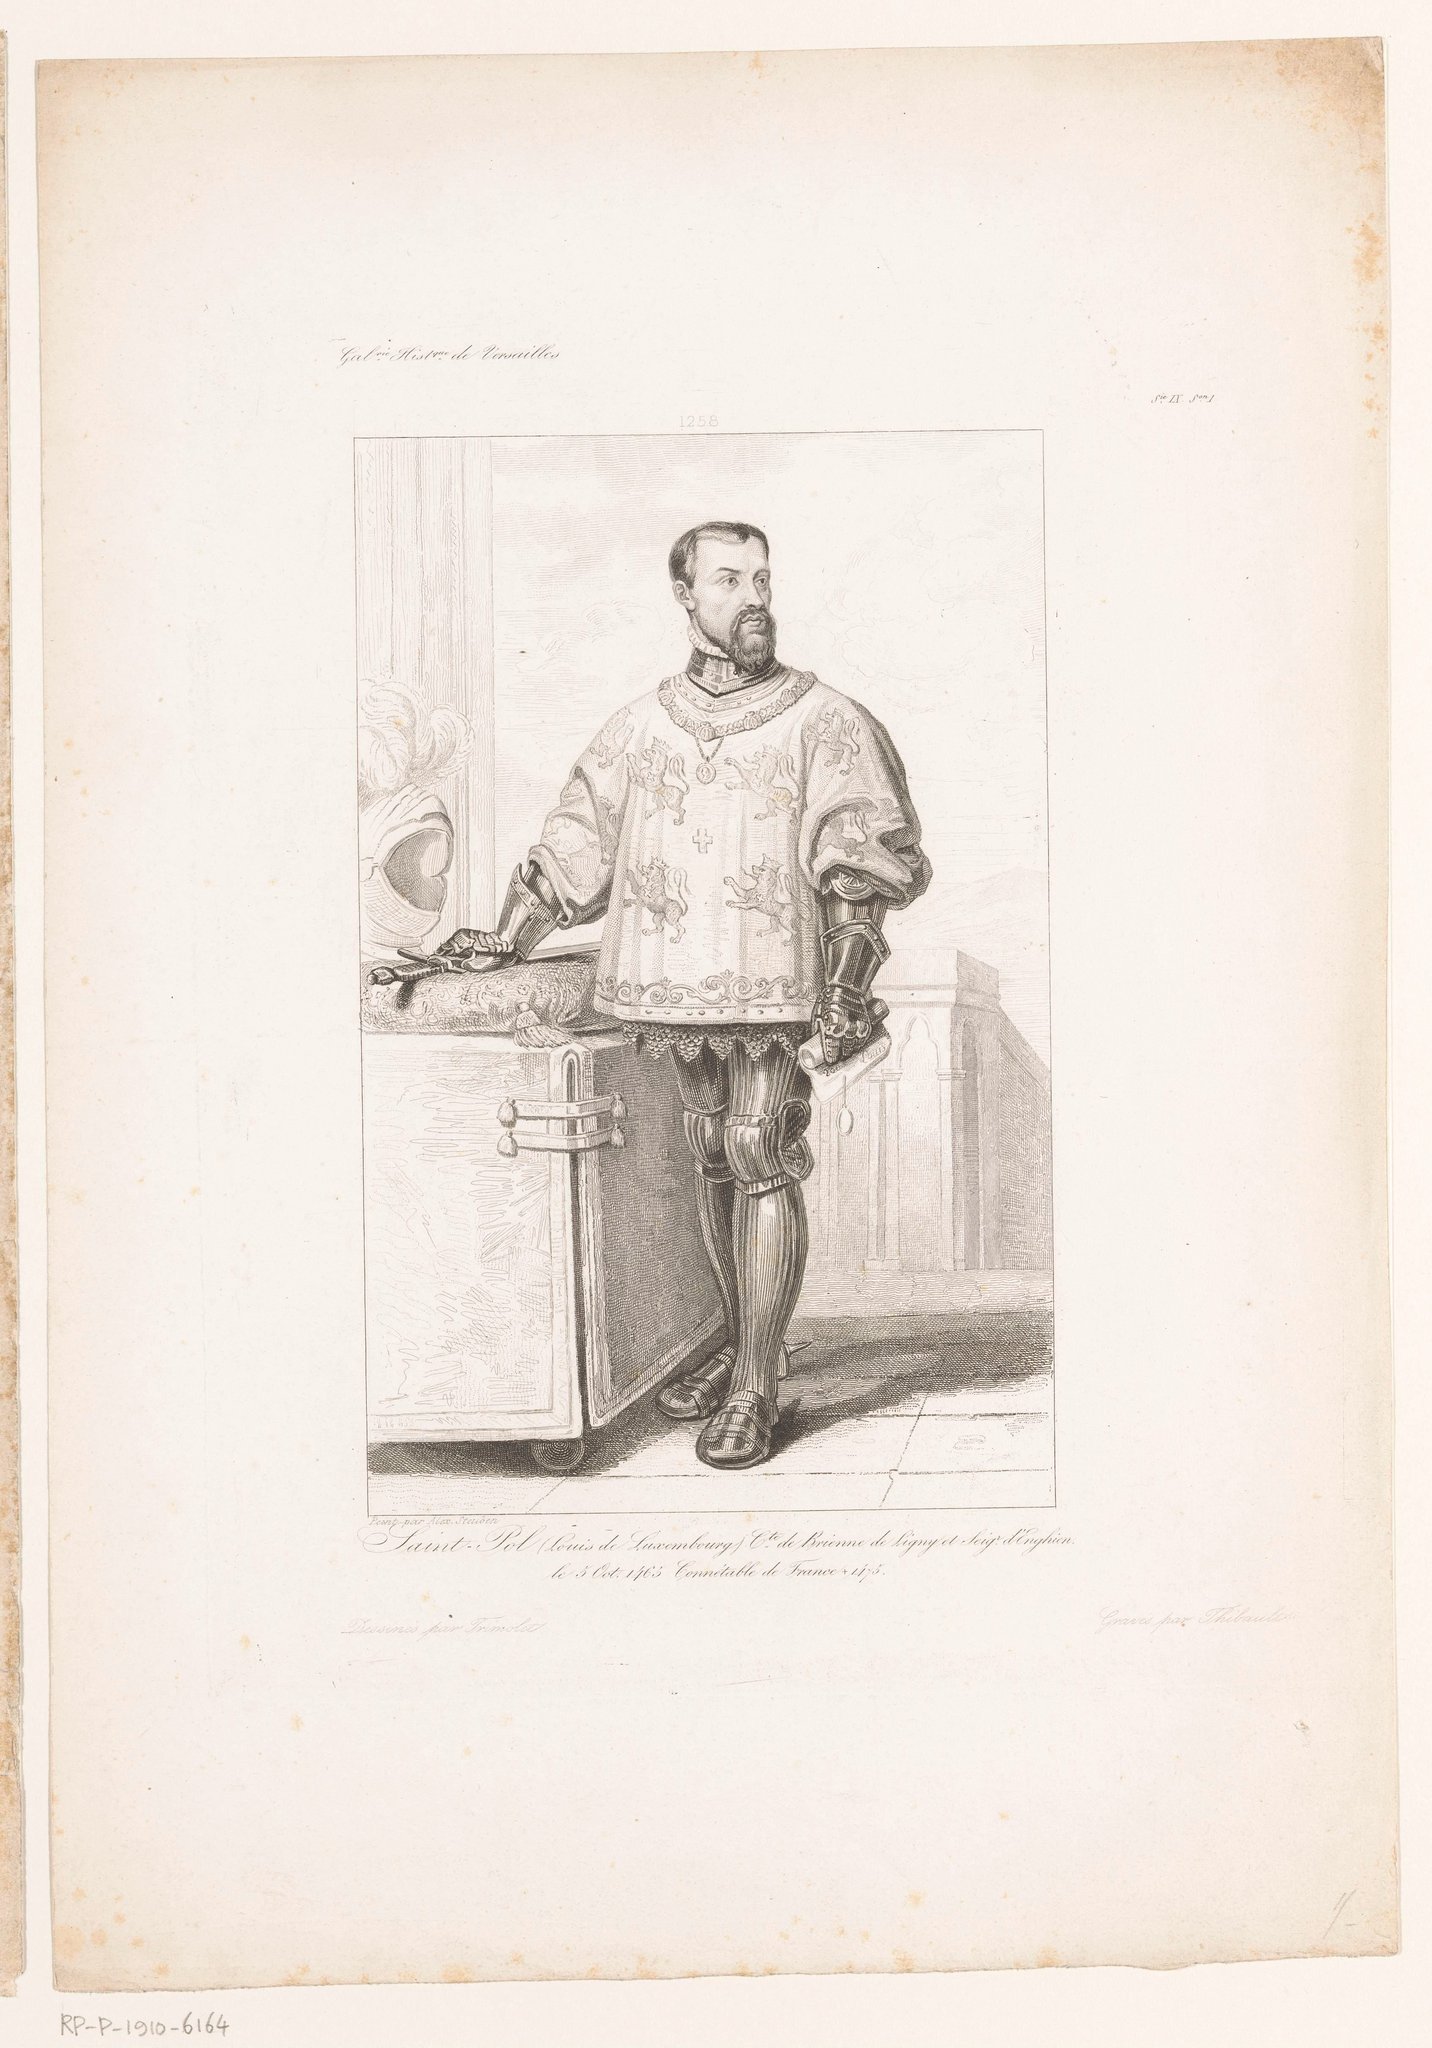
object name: print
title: Portret van Louis de Luxembourg-Saint Pol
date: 1838-1841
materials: paper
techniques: etching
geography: paris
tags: armour, historical persons, nobility and patriciate; chivalry, knighthood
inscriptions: collector's mark: Lugt 2228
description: Prent uit: s.n. Galeries historiques de Versailles. Parijs: Charles Gavard, 1838-1841.